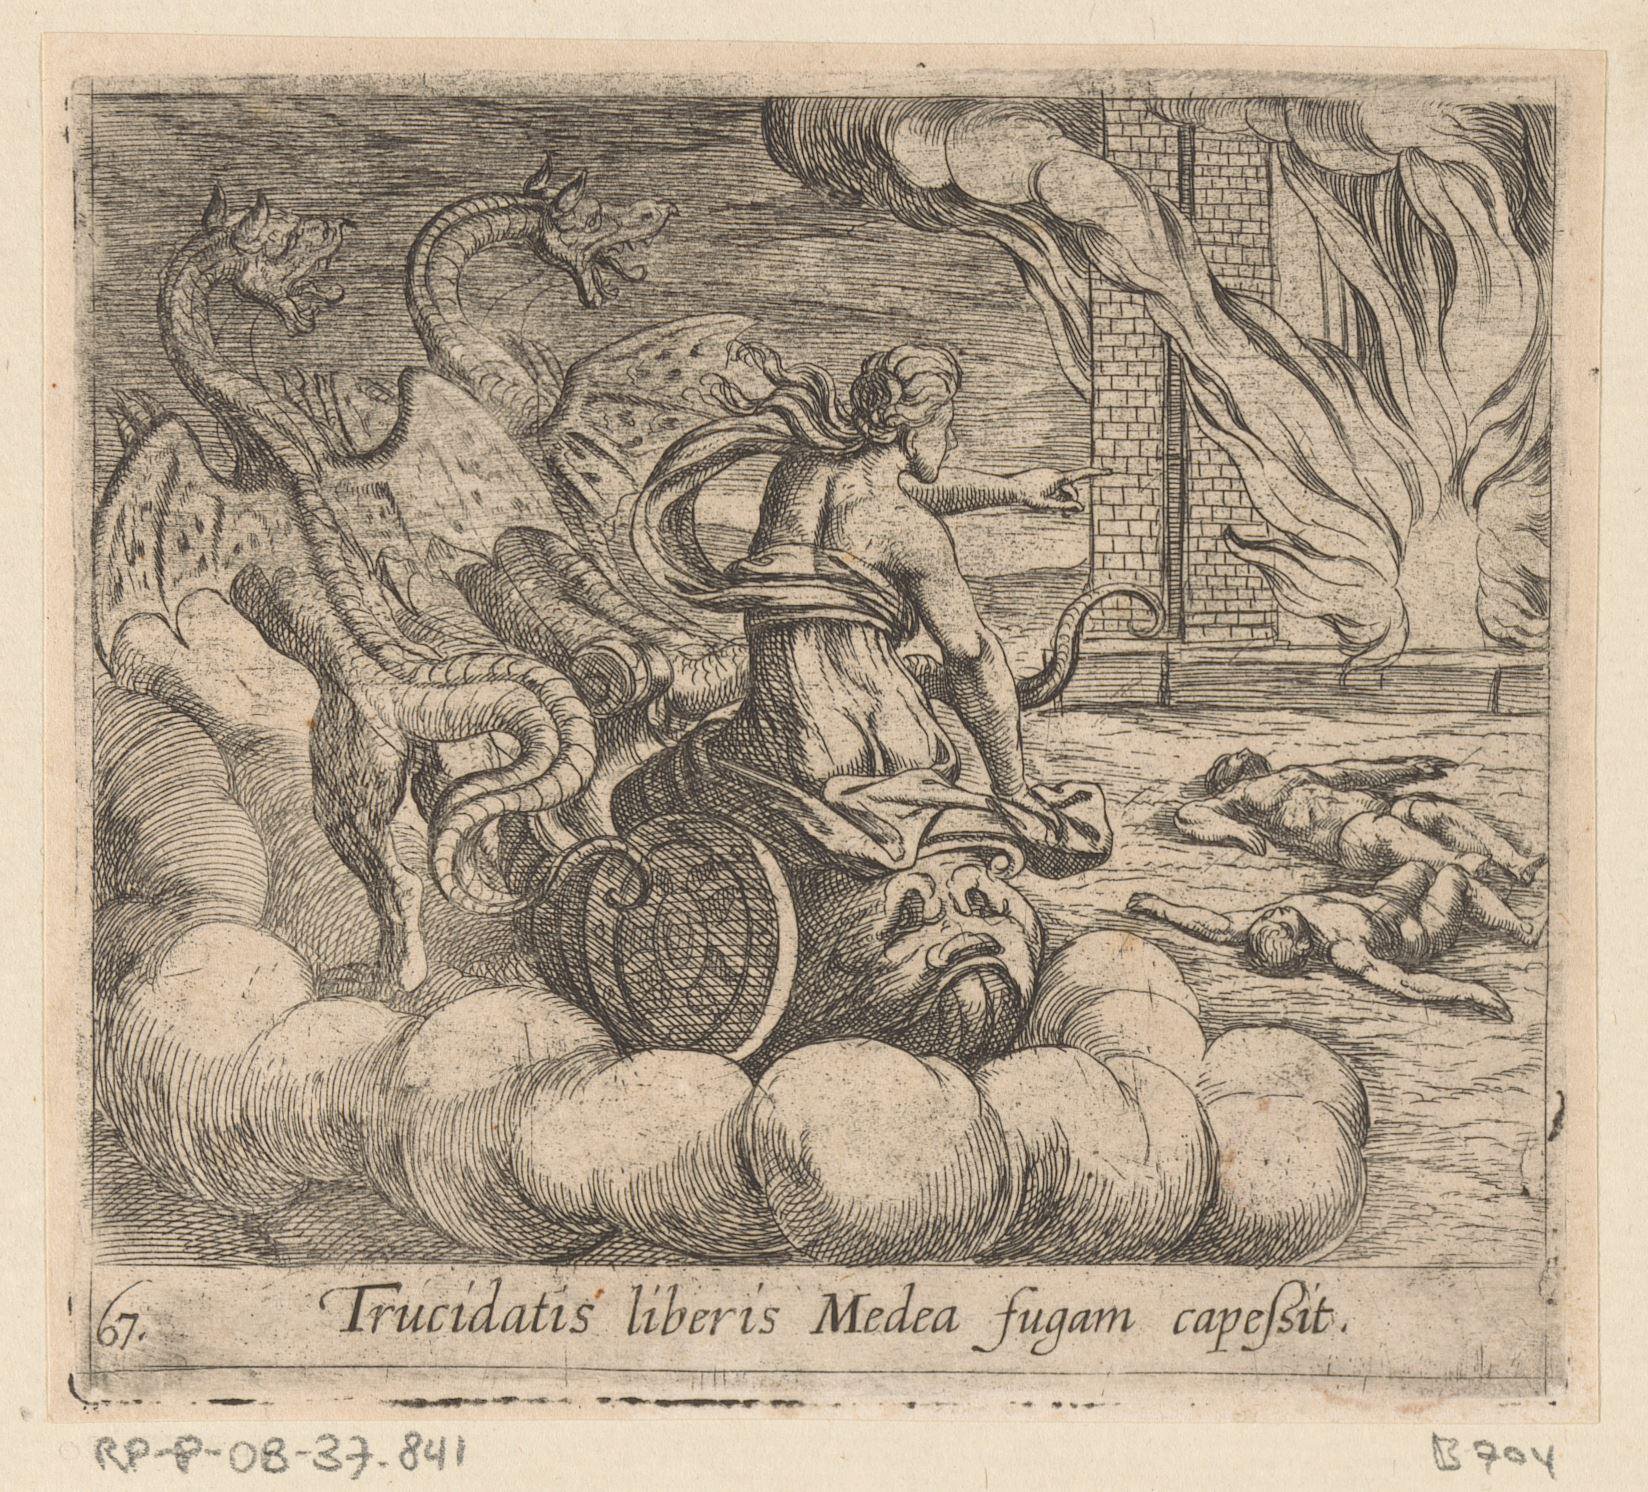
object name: print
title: Trucidatis liberis Medea fugam capessit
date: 1606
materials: paper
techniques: etching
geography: antwerp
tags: medea kills her two children; she flees from corinth in a chariot drawn by winged dragons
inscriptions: collector's mark: Lugt 240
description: Medea zit op haar wagen die wordt voortgetrokken door twee draken. Ze verwoest het huis en de familie van Jason. Het huis gaat in vlammen op. Titel in het Latijn in ondermarge.